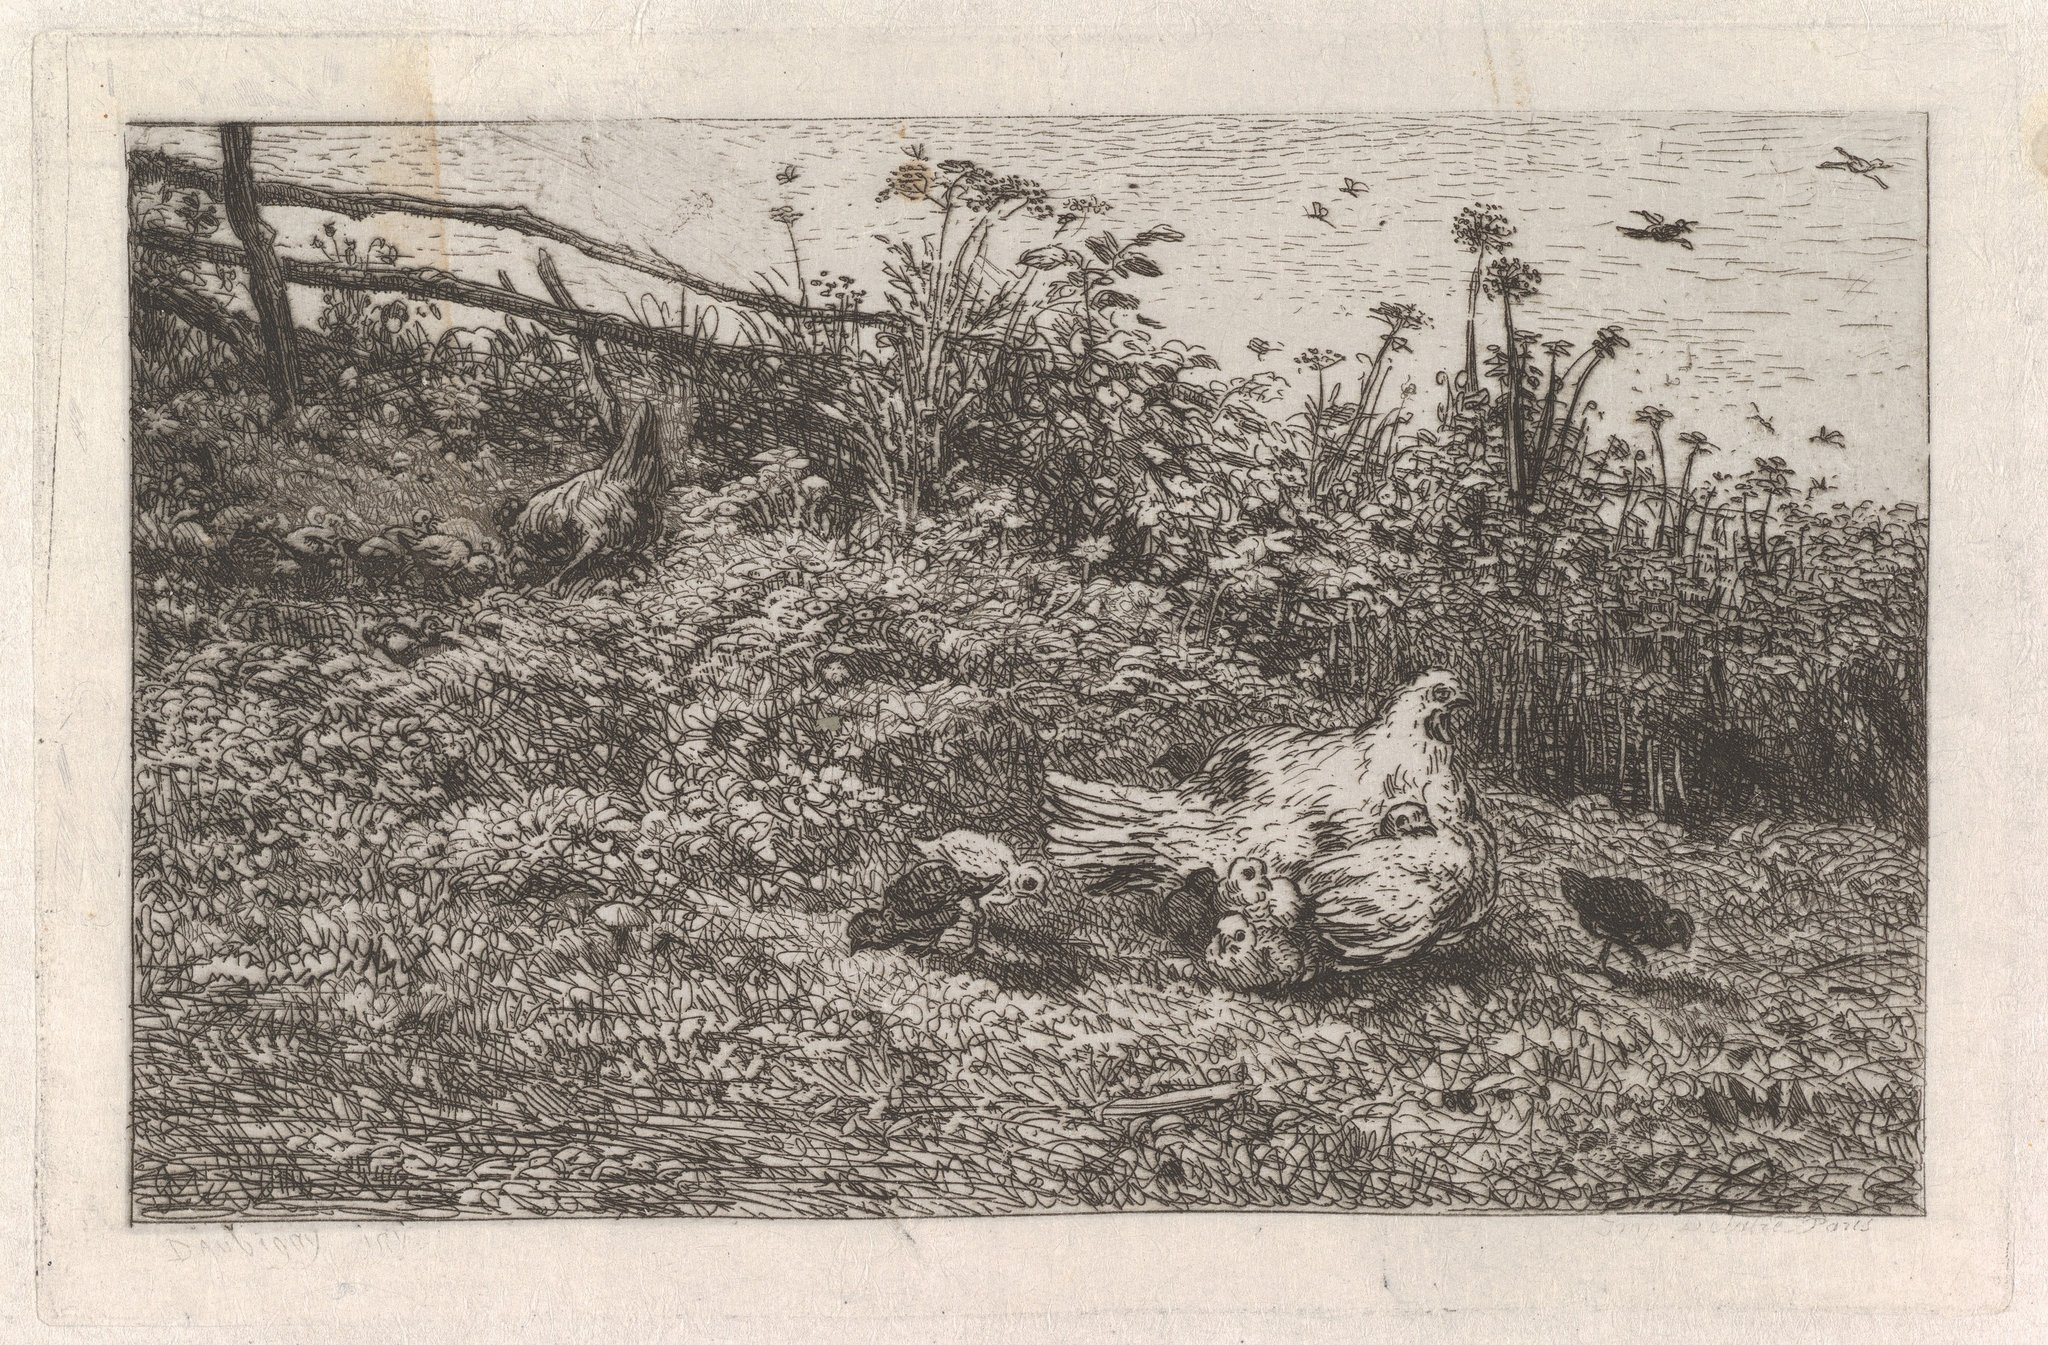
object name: print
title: Le Poule et ses Poussins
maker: charles-françois daubigny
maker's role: artist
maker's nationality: french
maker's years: 1817-1878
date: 1860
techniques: etching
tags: chickens